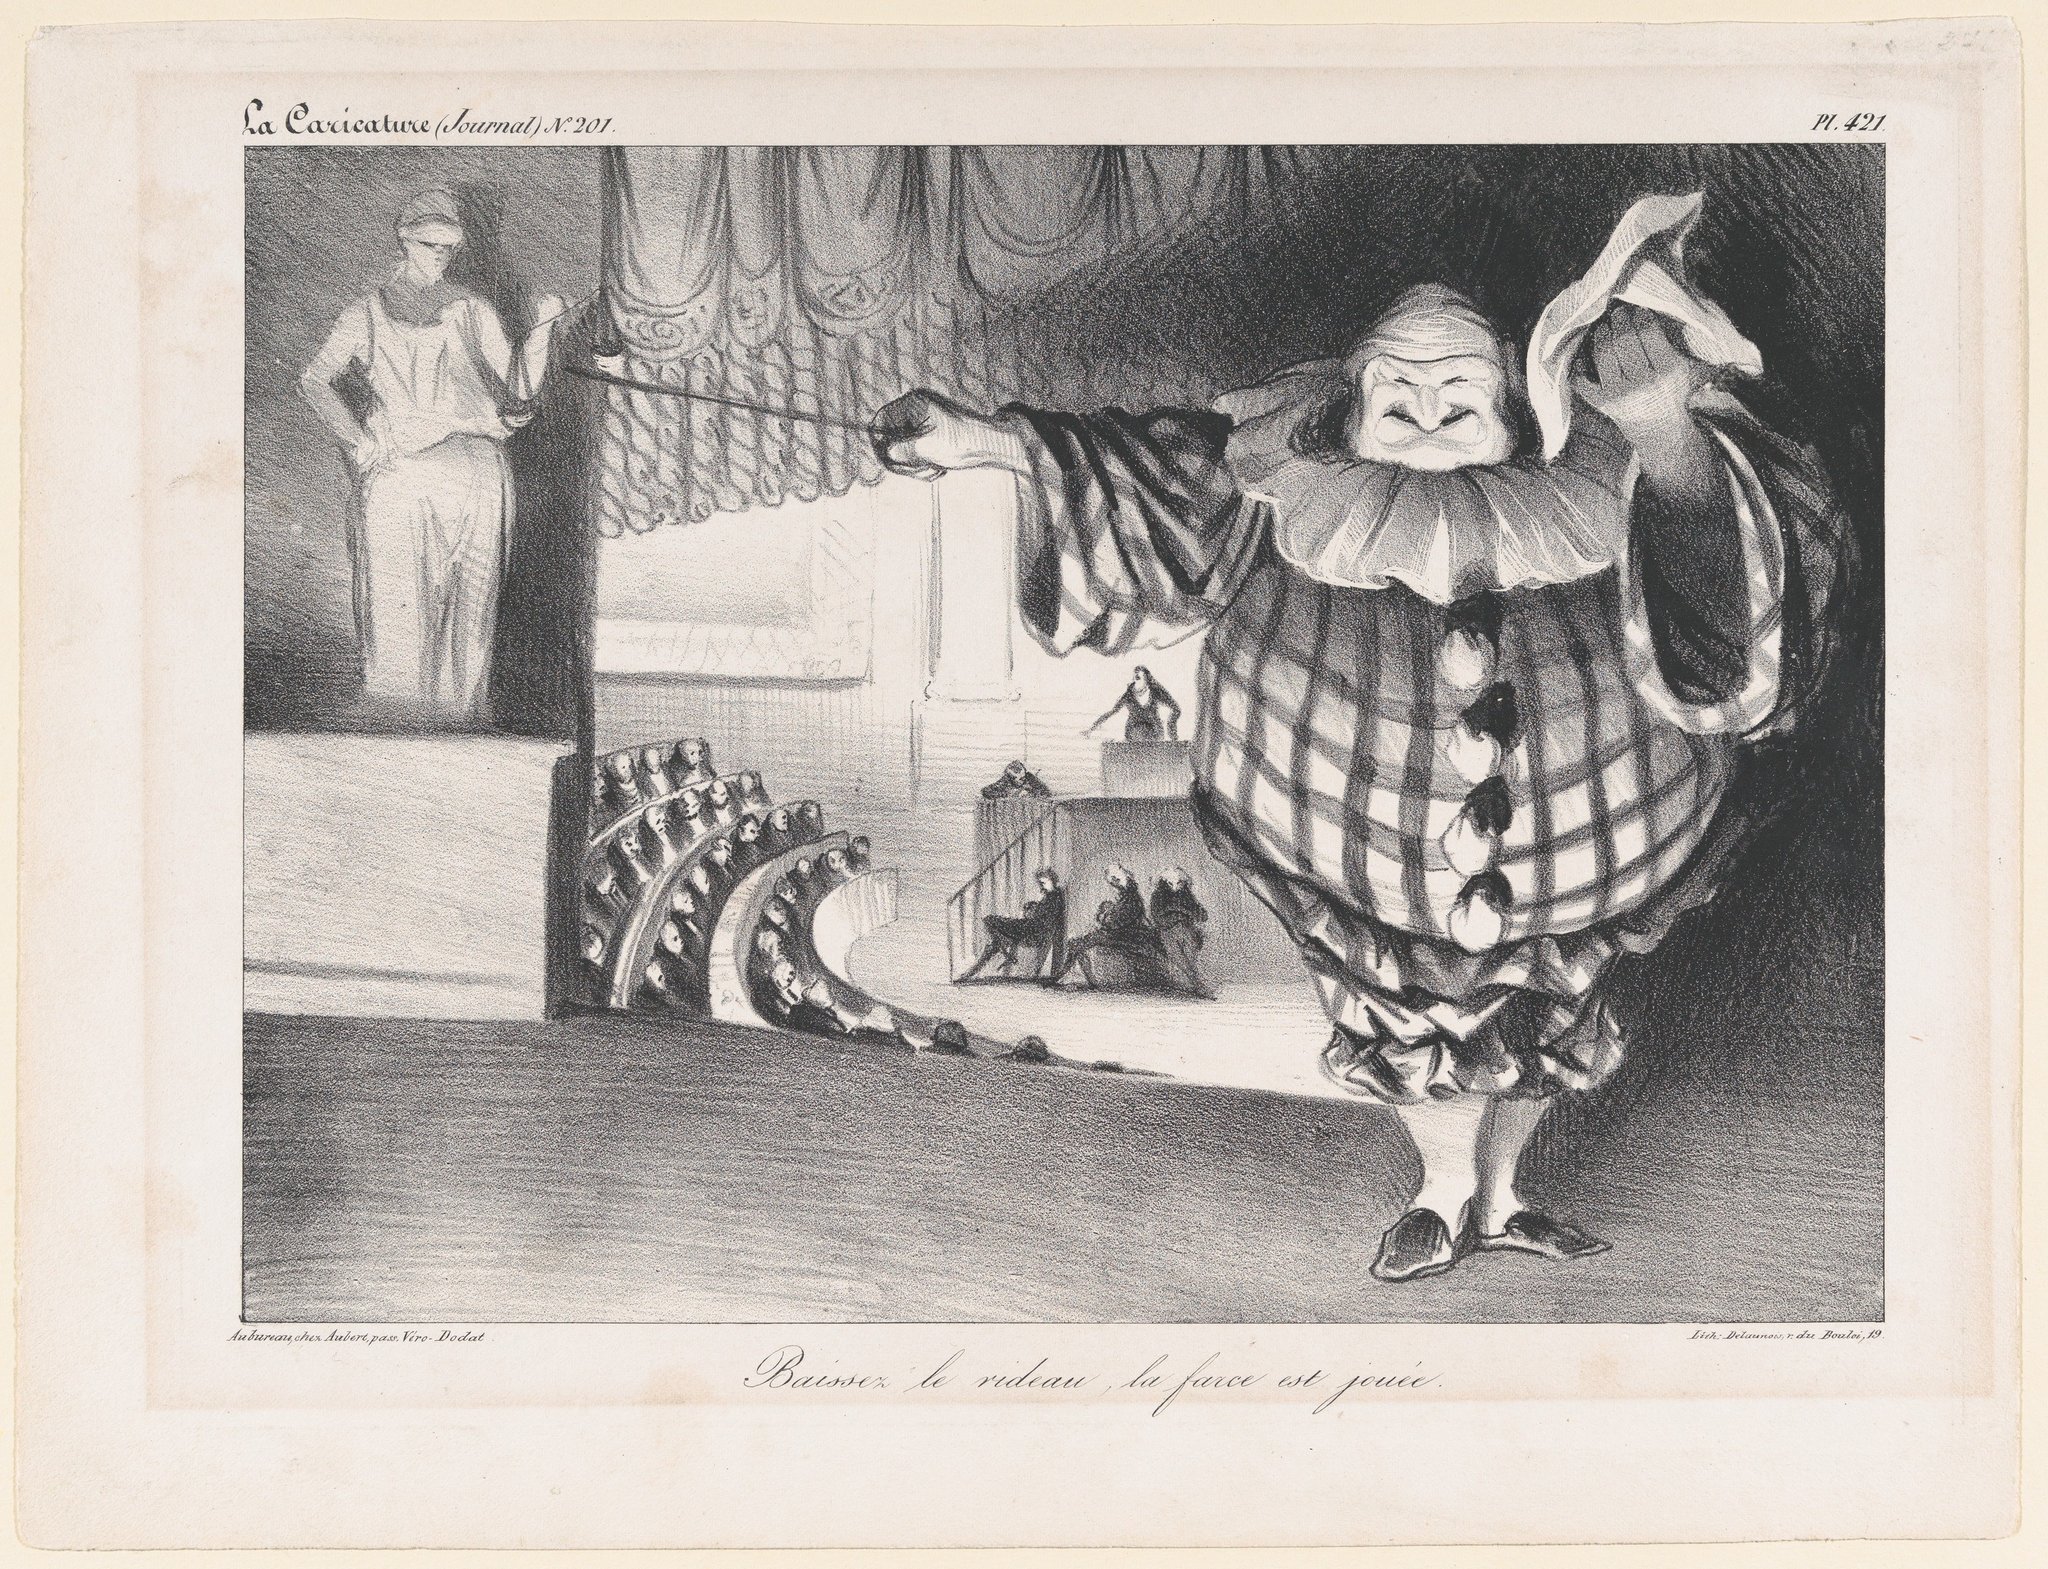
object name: print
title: Baissez le Rideau, La Farce est Jouée (Bring Down the Curtain; the Farce is Over), published in La Caricature no. 201, September 11, 1834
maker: honoré daumier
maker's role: artist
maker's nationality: french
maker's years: 1808-1879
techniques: lithograph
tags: theatre,spectators,clowns